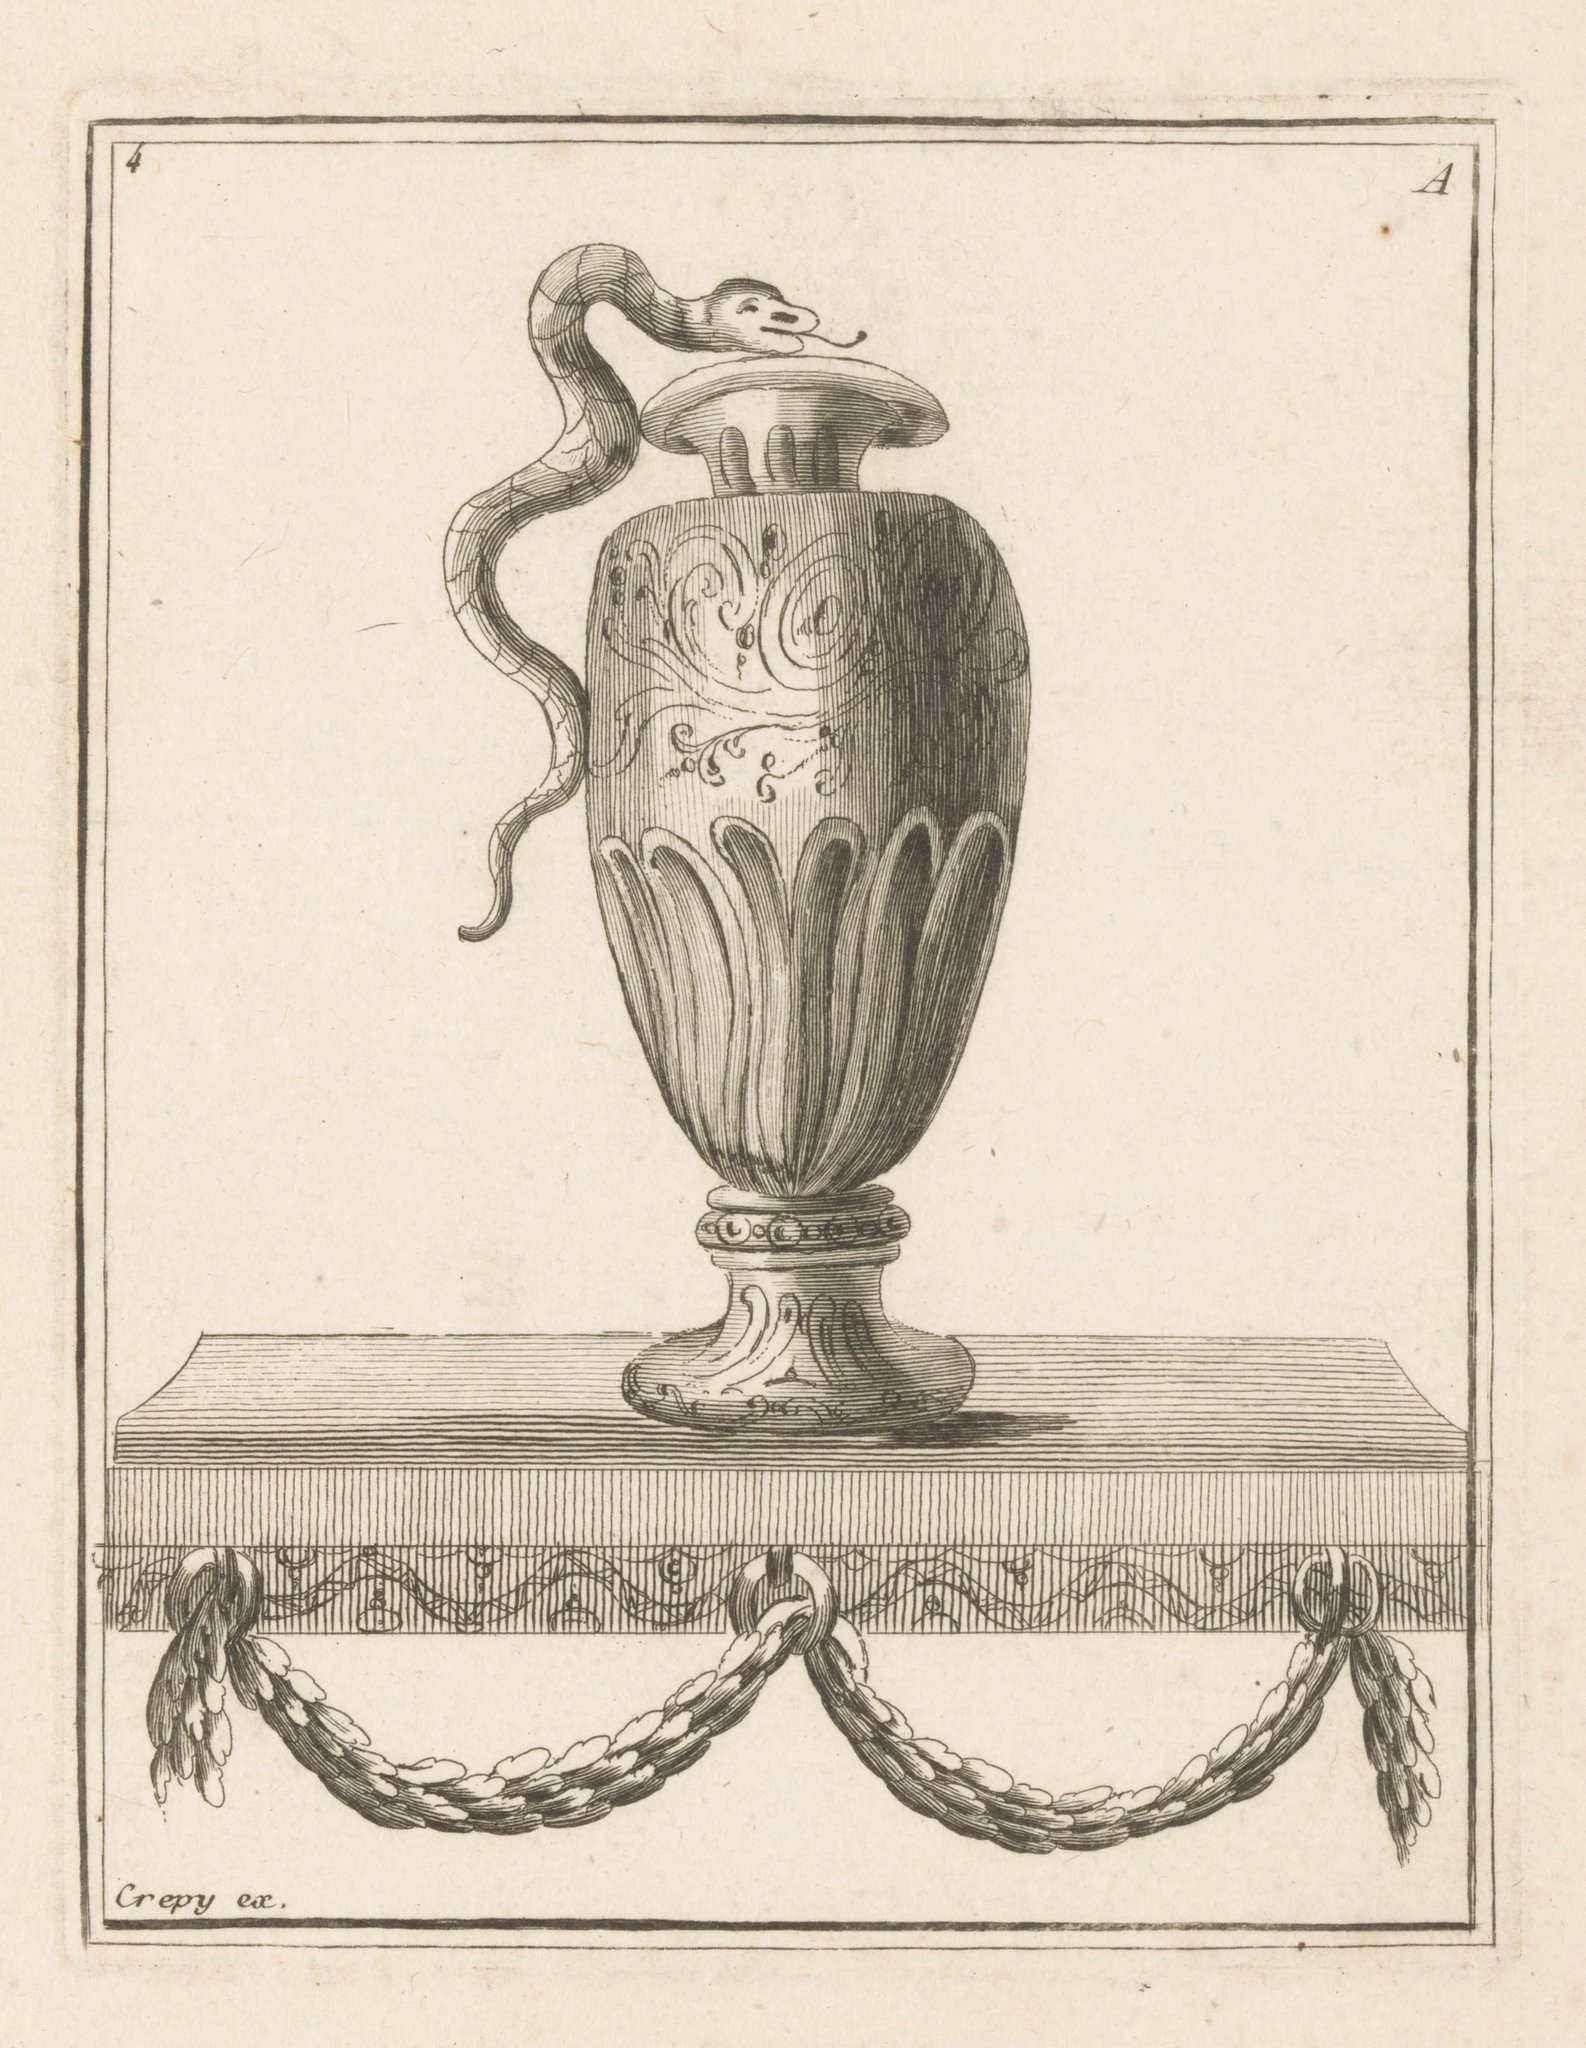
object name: ornament print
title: Vaas met slang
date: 1770-1780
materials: paper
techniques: etching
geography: paris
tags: snakes, vase ~ ornament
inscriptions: collector's mark: Lugt 2760, collector's mark: Lugt 2228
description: Een geornamenteerde vaas met een slang. Daaronder een guirlande. Rechts boven A genummerd.